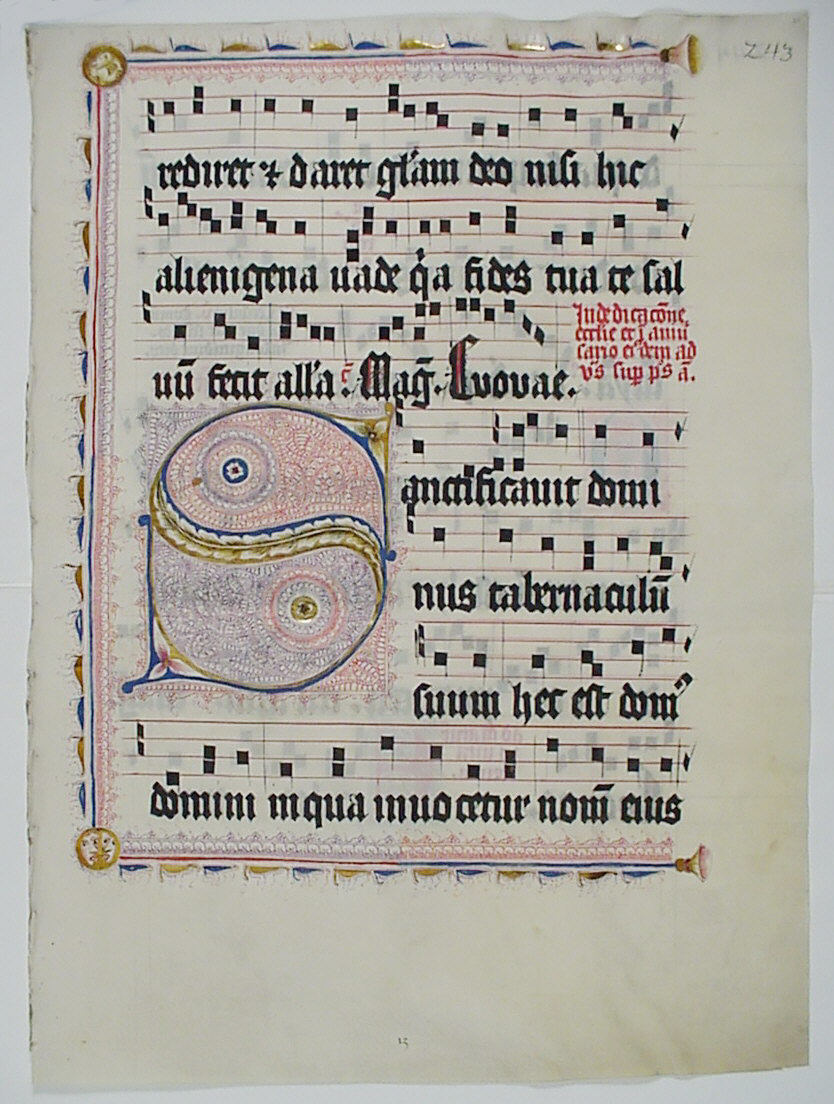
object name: antiphonary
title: Manuscript Leaf with Initial S, from an Antiphonary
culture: german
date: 1426-1450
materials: ink, metal leaf, parchment, paint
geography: germany